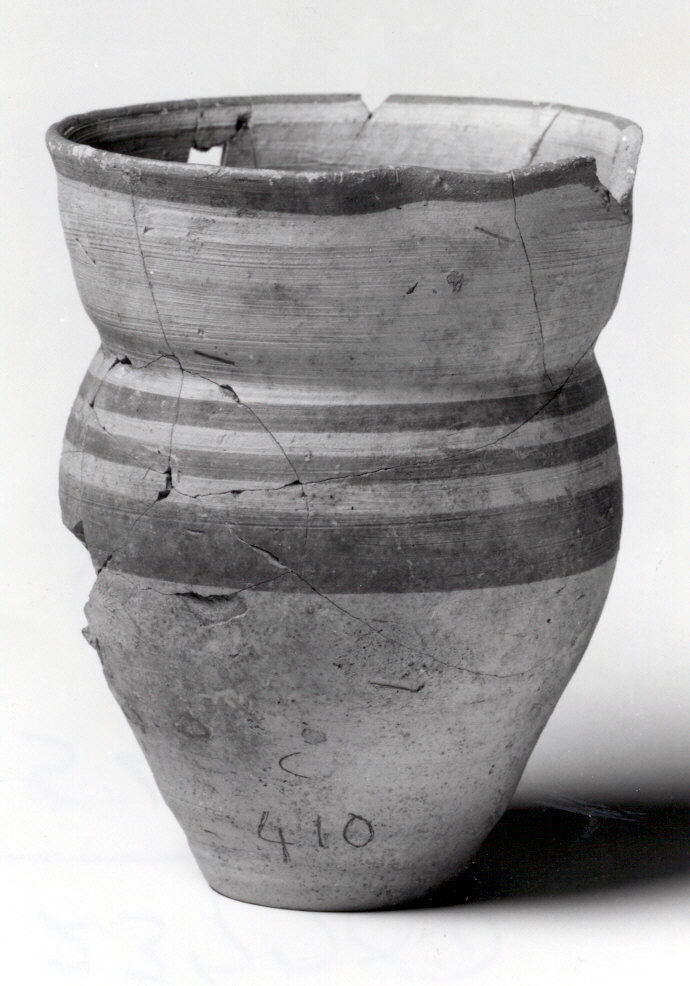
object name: beaker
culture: mitanni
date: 1600 BCE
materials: ceramic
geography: mesopotamia